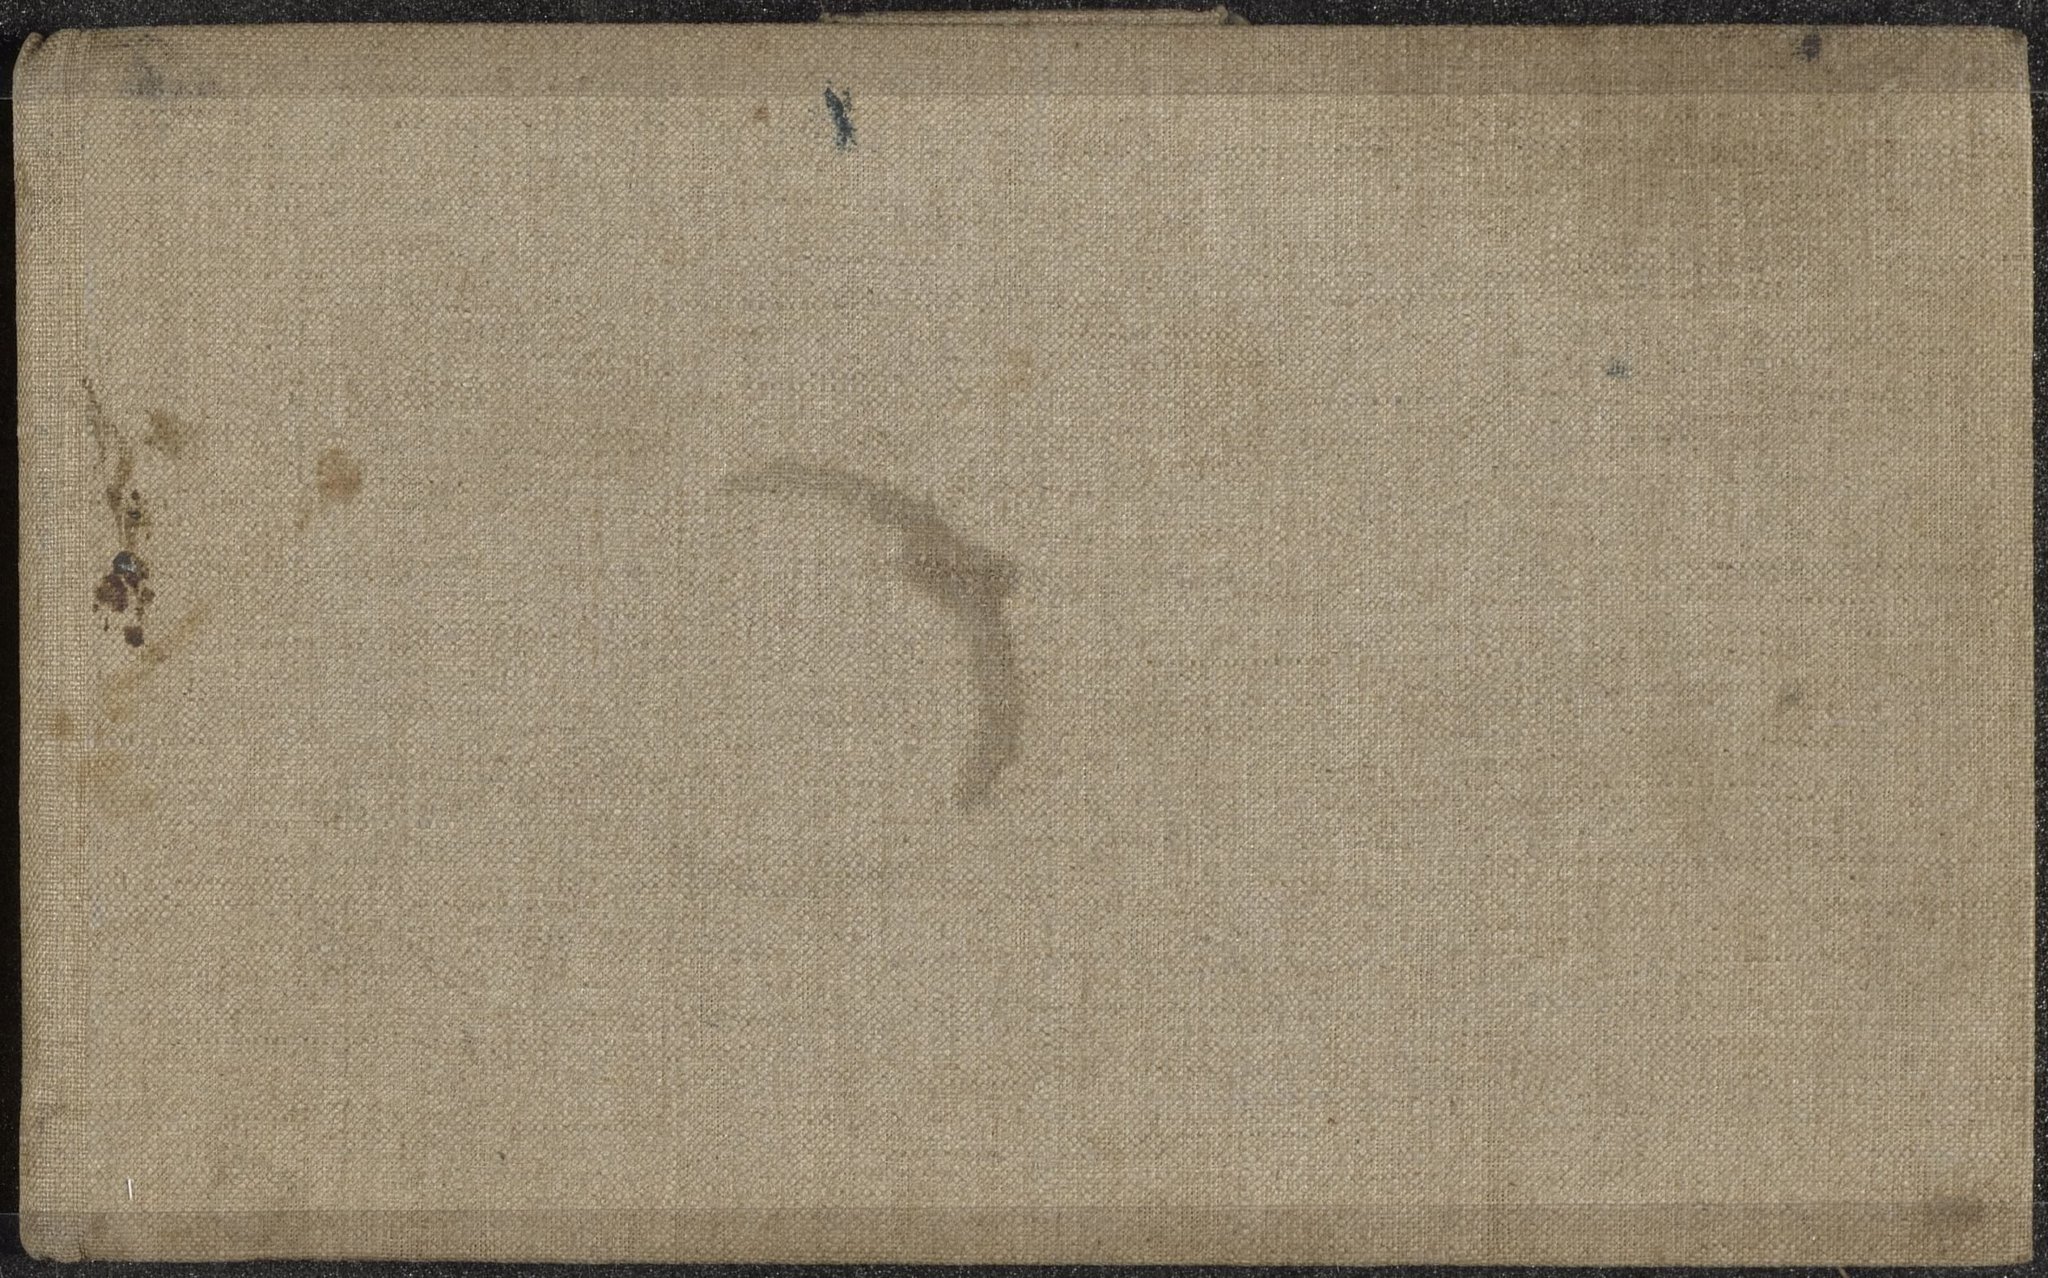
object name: sketchbook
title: Schetsboek met 48 bladen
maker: george hendrik breitner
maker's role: draughtsman, painter, print maker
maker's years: 1857-1923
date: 1883-1885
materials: cardboard, chalk, linen, paper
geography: drenthe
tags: adult woman, anonymous historical person portrayed alone, adult man, farm (building)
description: Schetsboek bestaande uit 48 bladen met figuurstudies en boerderijen.